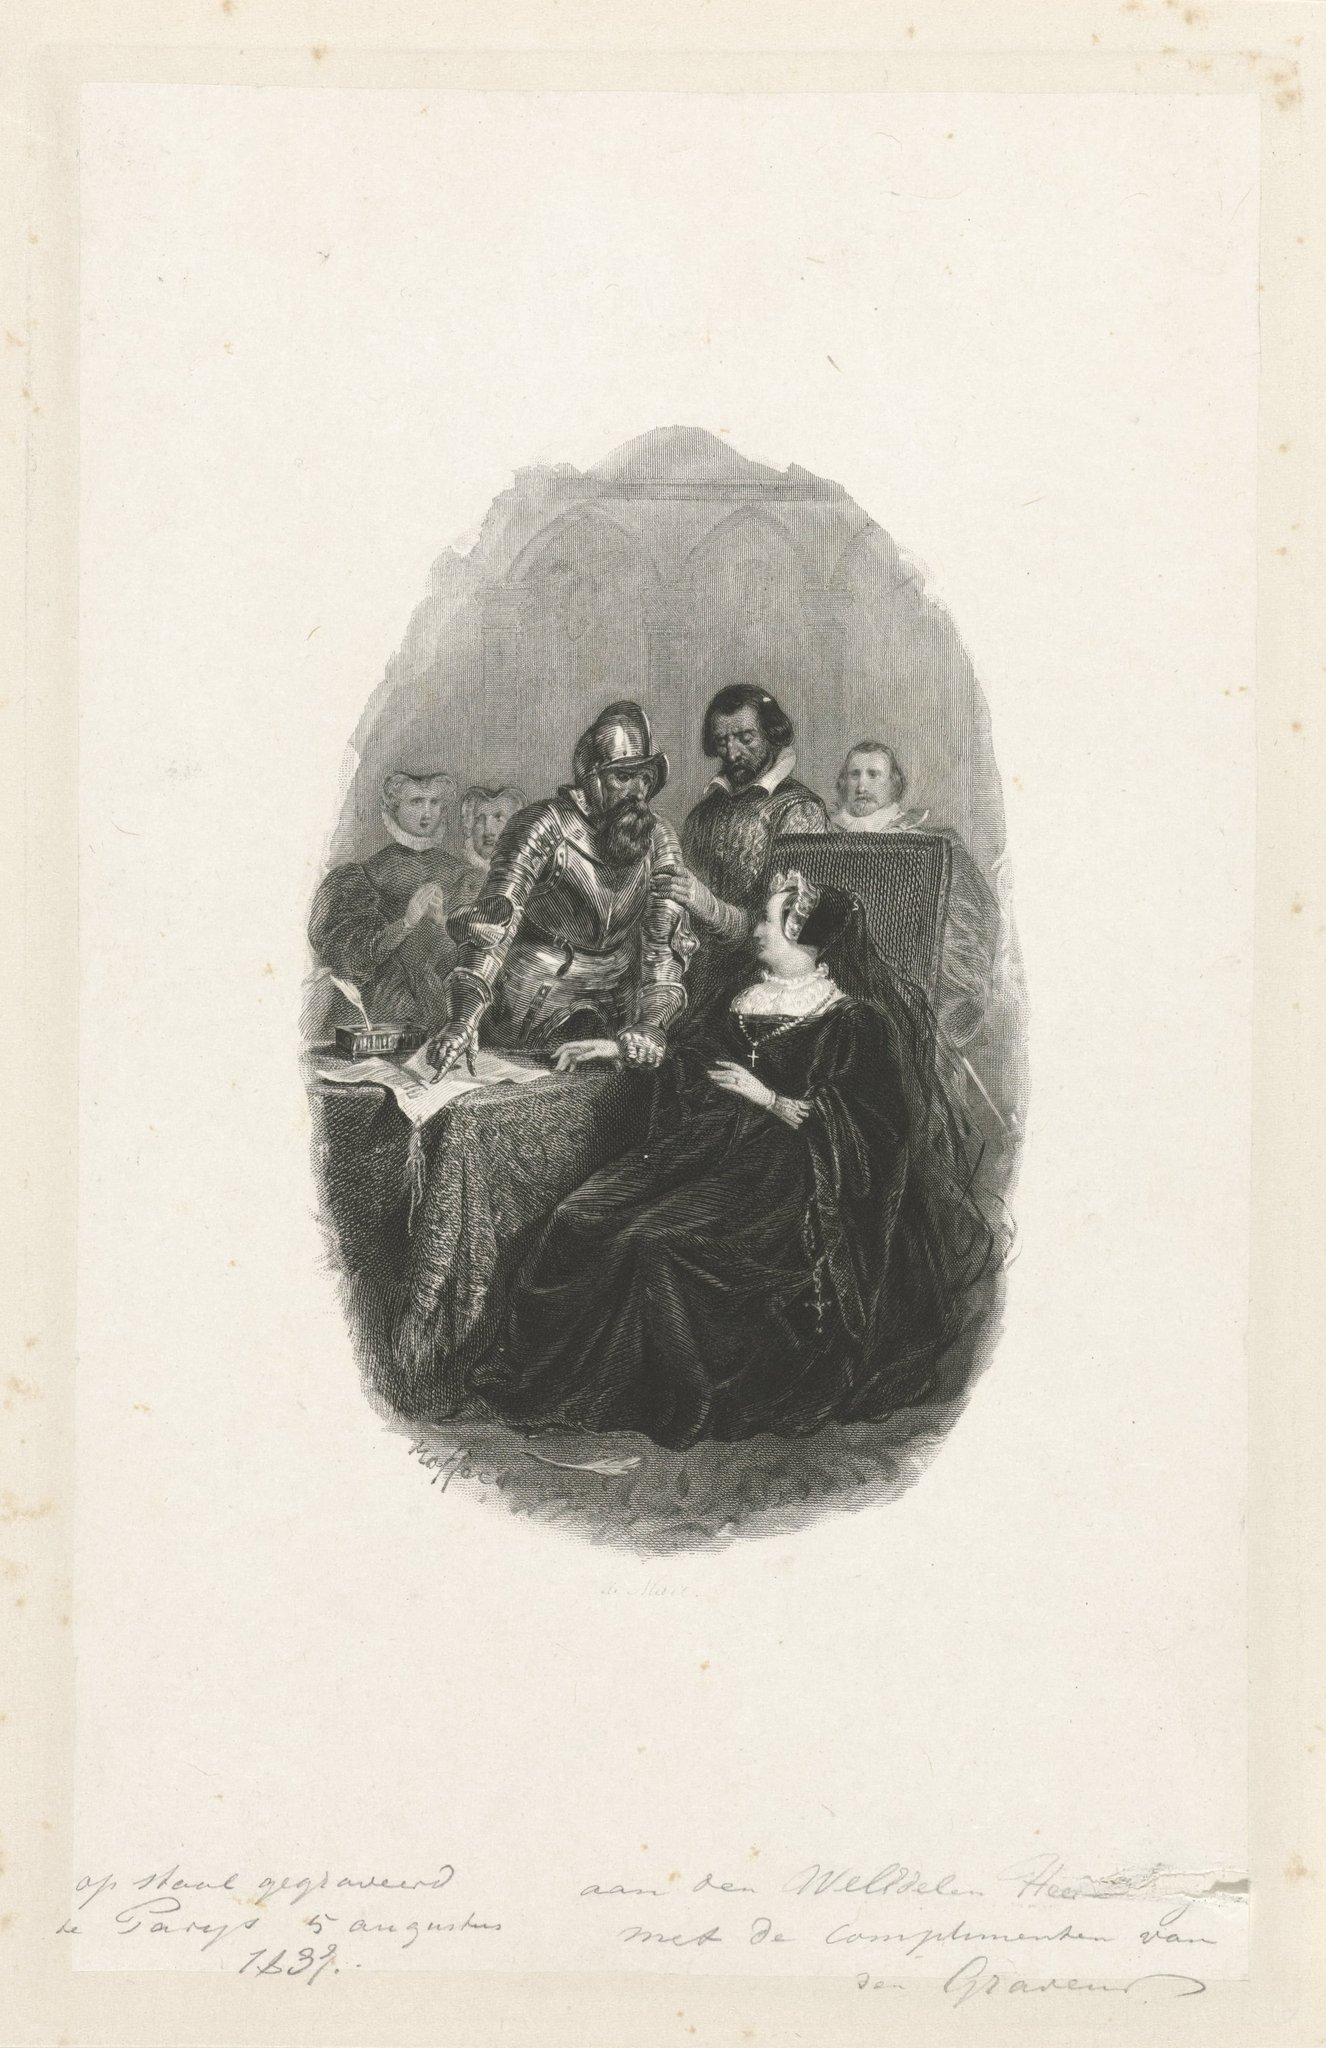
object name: print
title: Ridder bij een zittende dame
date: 1837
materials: paper, pencil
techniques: engraving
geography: paris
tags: quill, armour, handwriting, written text, index finger forwards, pointing, indicating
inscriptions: inscription: ‘op staal gegraveerd/ te Parijs 5 augustus/ 1837’, collector's mark: Lugt 2228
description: Een man met een baard in een harnas pakt een zittende, in het zwart geklede, dame bij haar pols en wijst op een document waaraan een zegel hangt. Op de grond ligt een schrijfveer.